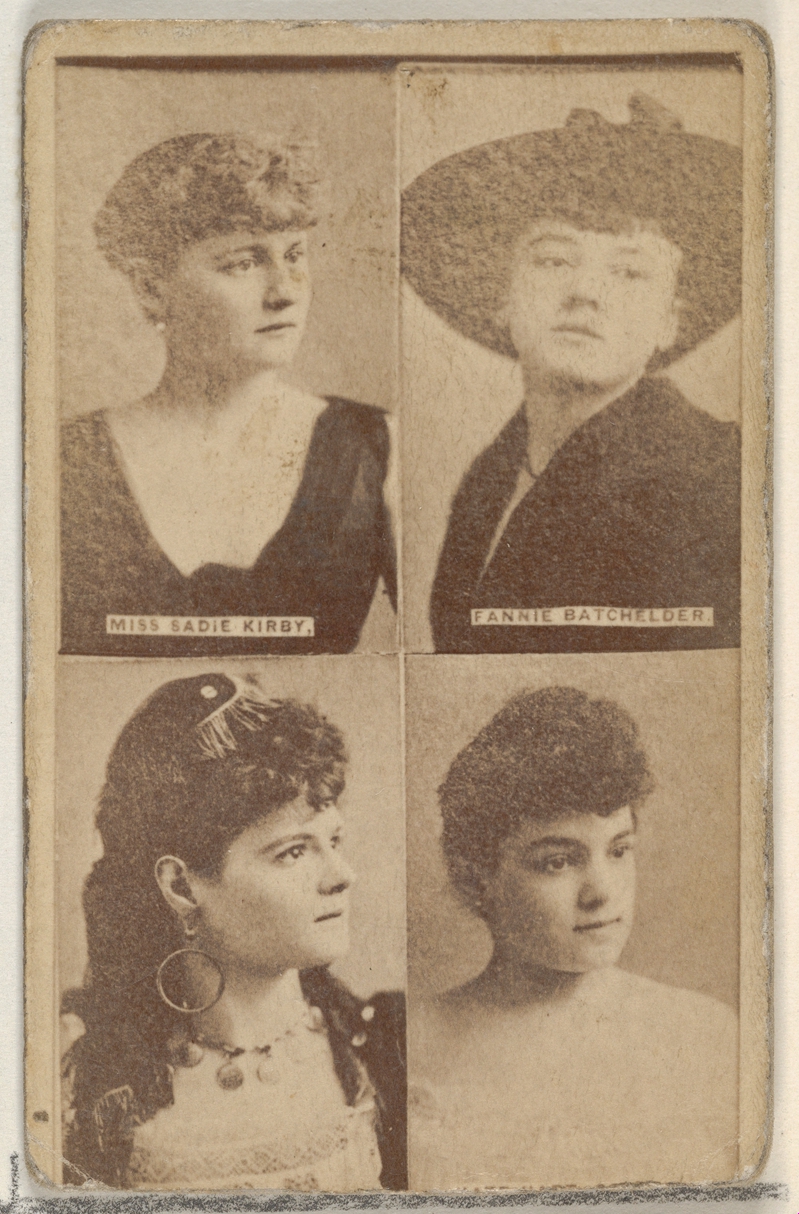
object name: photograph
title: Miss Sadie Kirby/ Fannie Batchelder, from the Actors and Actresses series (N45, Type 4) for Virginia Brights Cigarettes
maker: allen & ginter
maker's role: publisher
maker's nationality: american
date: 1888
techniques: albumen silver print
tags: portraits,women,actresses